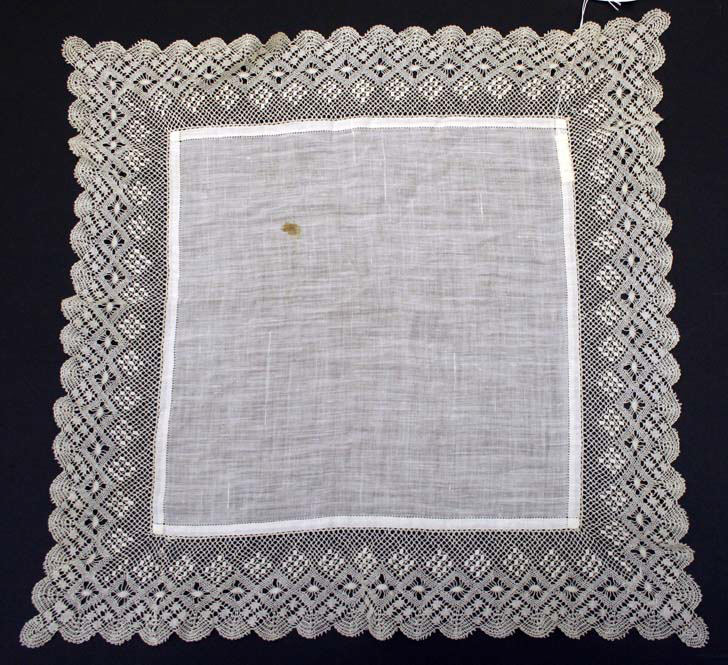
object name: handkerchief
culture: french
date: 1880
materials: linen